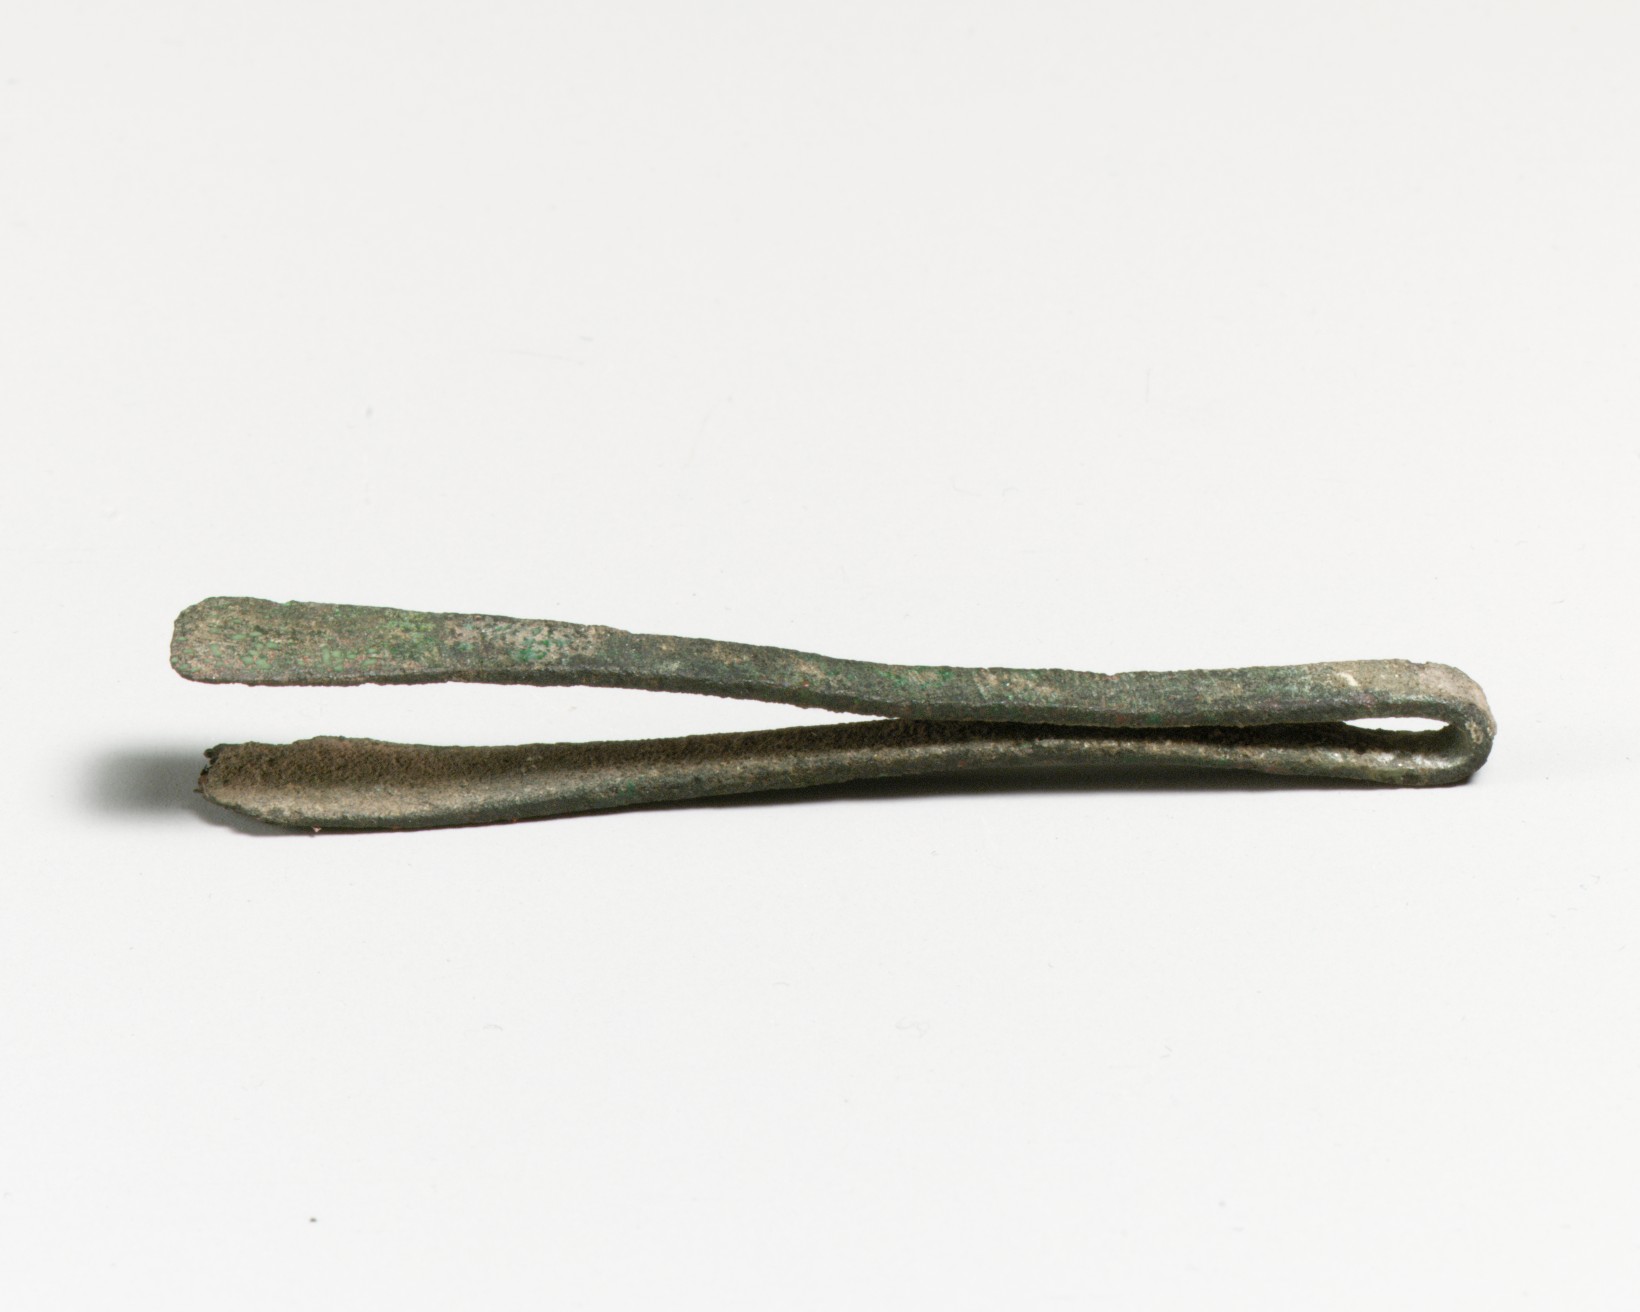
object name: tweezer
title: Tweezers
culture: cypriot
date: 3200-2000 BCE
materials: bronze